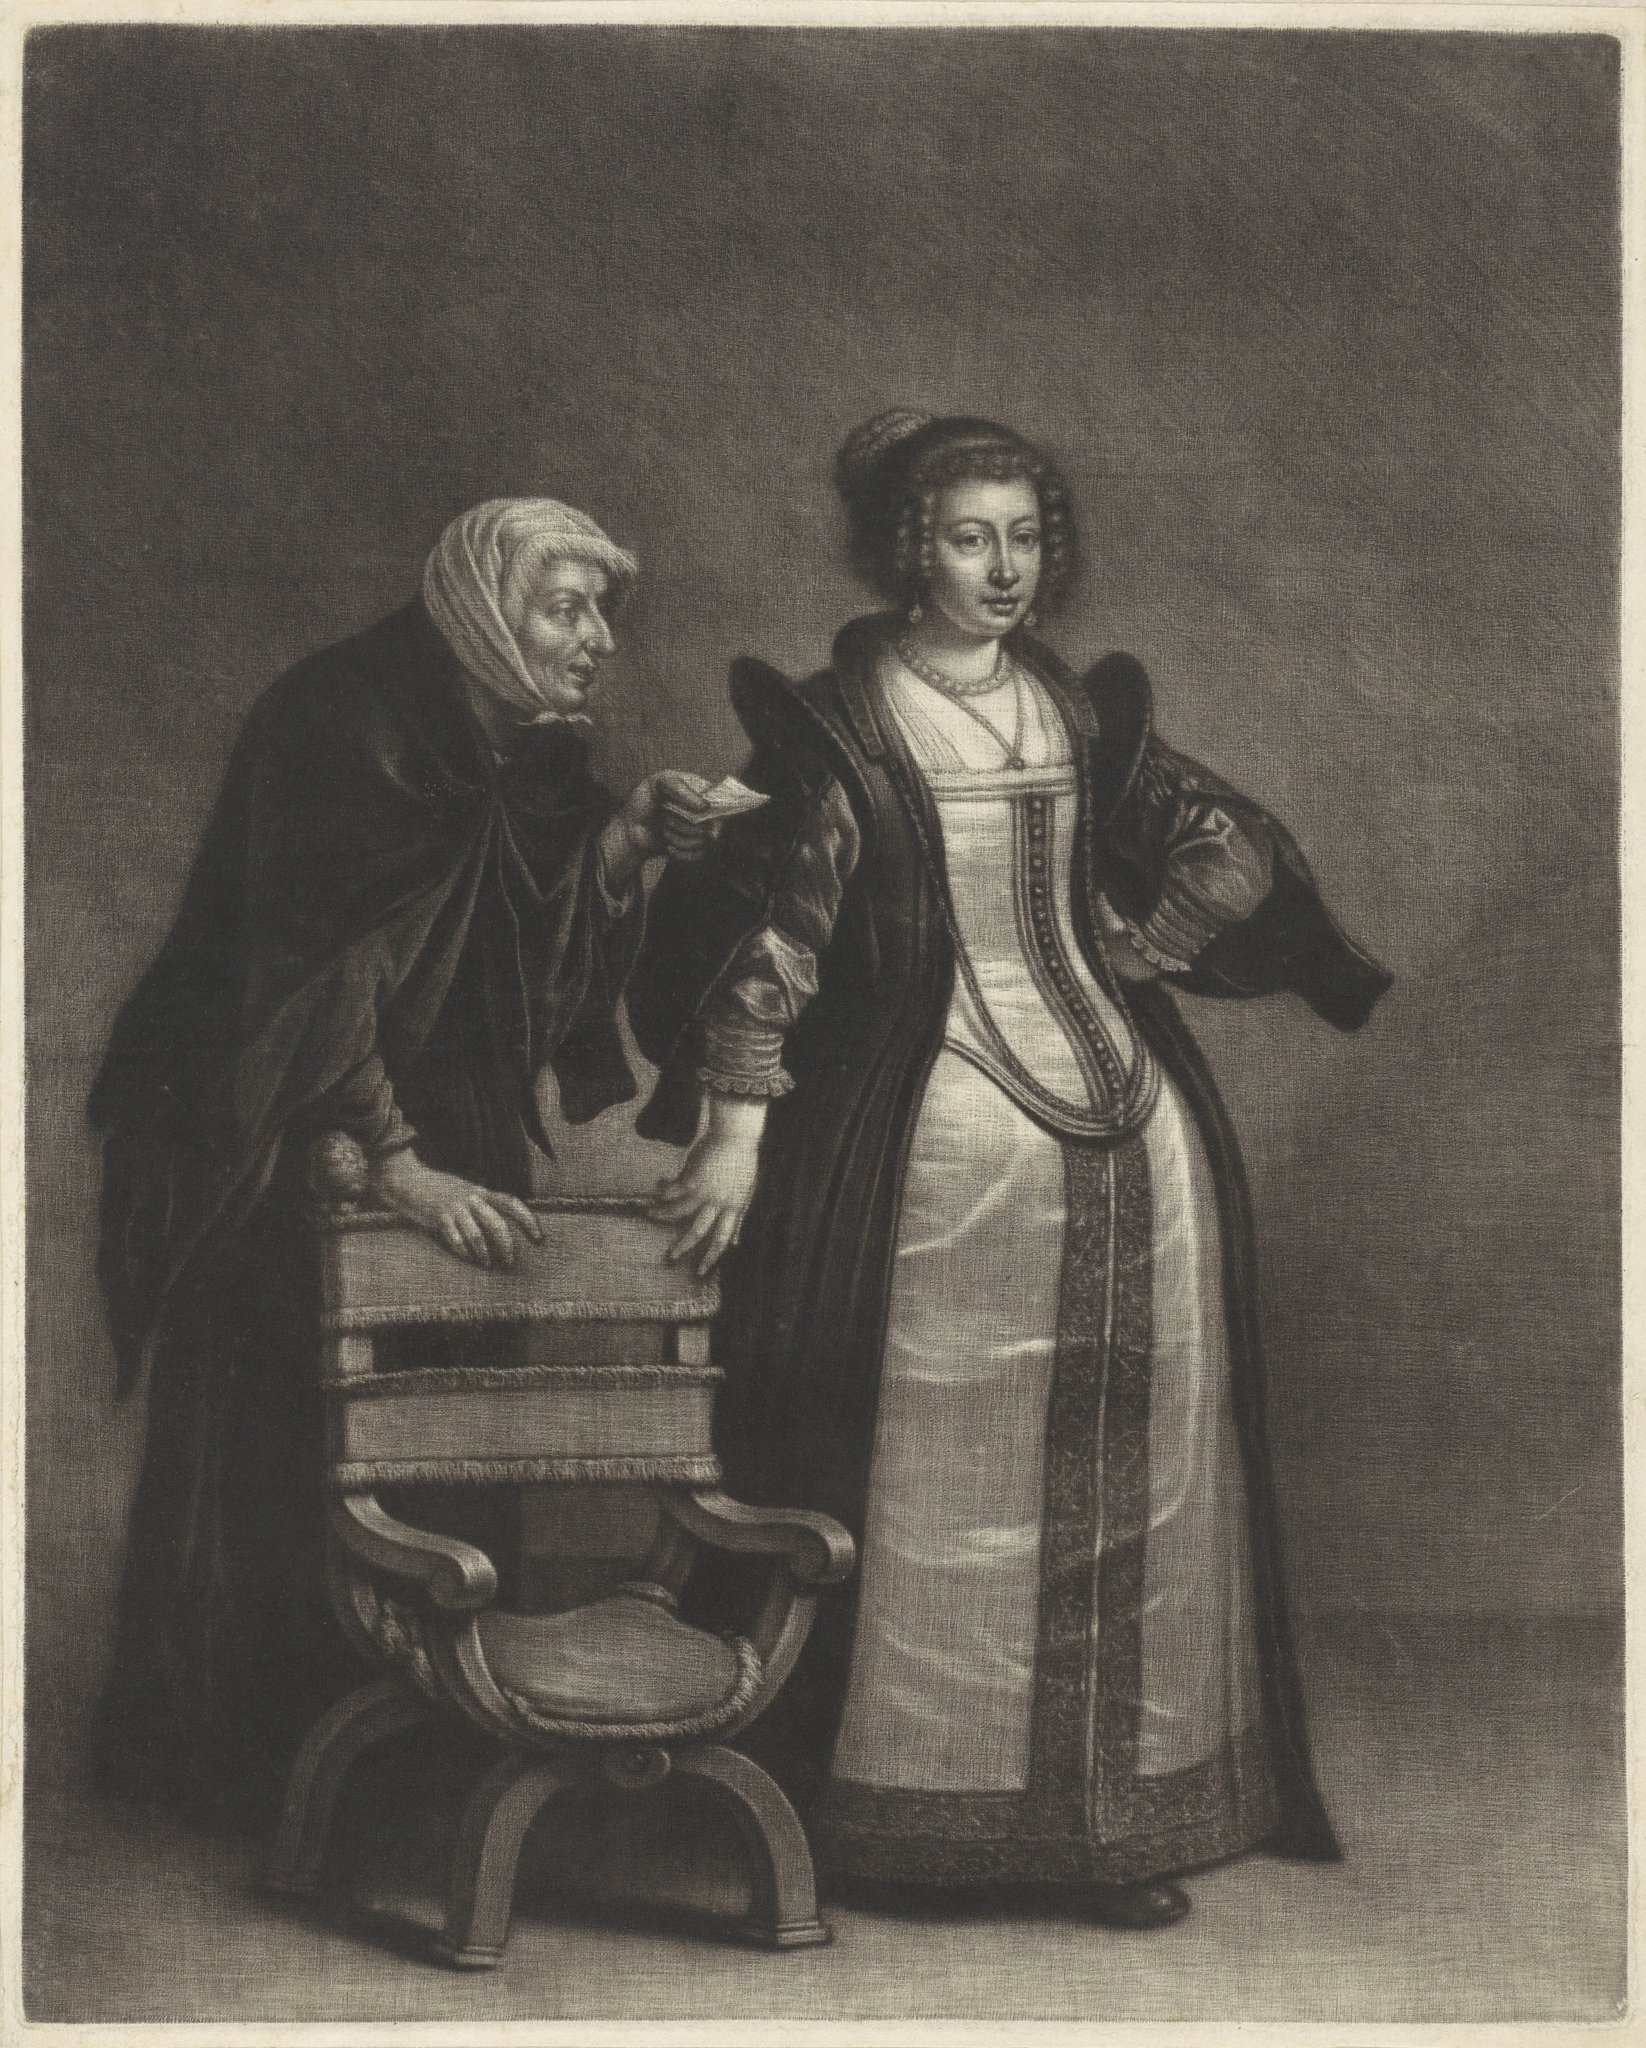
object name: print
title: Overhandiging van een brief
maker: wallerant vaillant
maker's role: draughtsman, painter, print maker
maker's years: 1623-1677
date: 1658-1677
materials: paper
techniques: mezzotint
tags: letter, envelope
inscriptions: collector's mark: Lugt 10, collector's mark: Lugt 11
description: Een oude vrouw steunt op een stoel en overhandigt een brief aan een jonge vrouw, die dezelfde stoel vasthoudt.